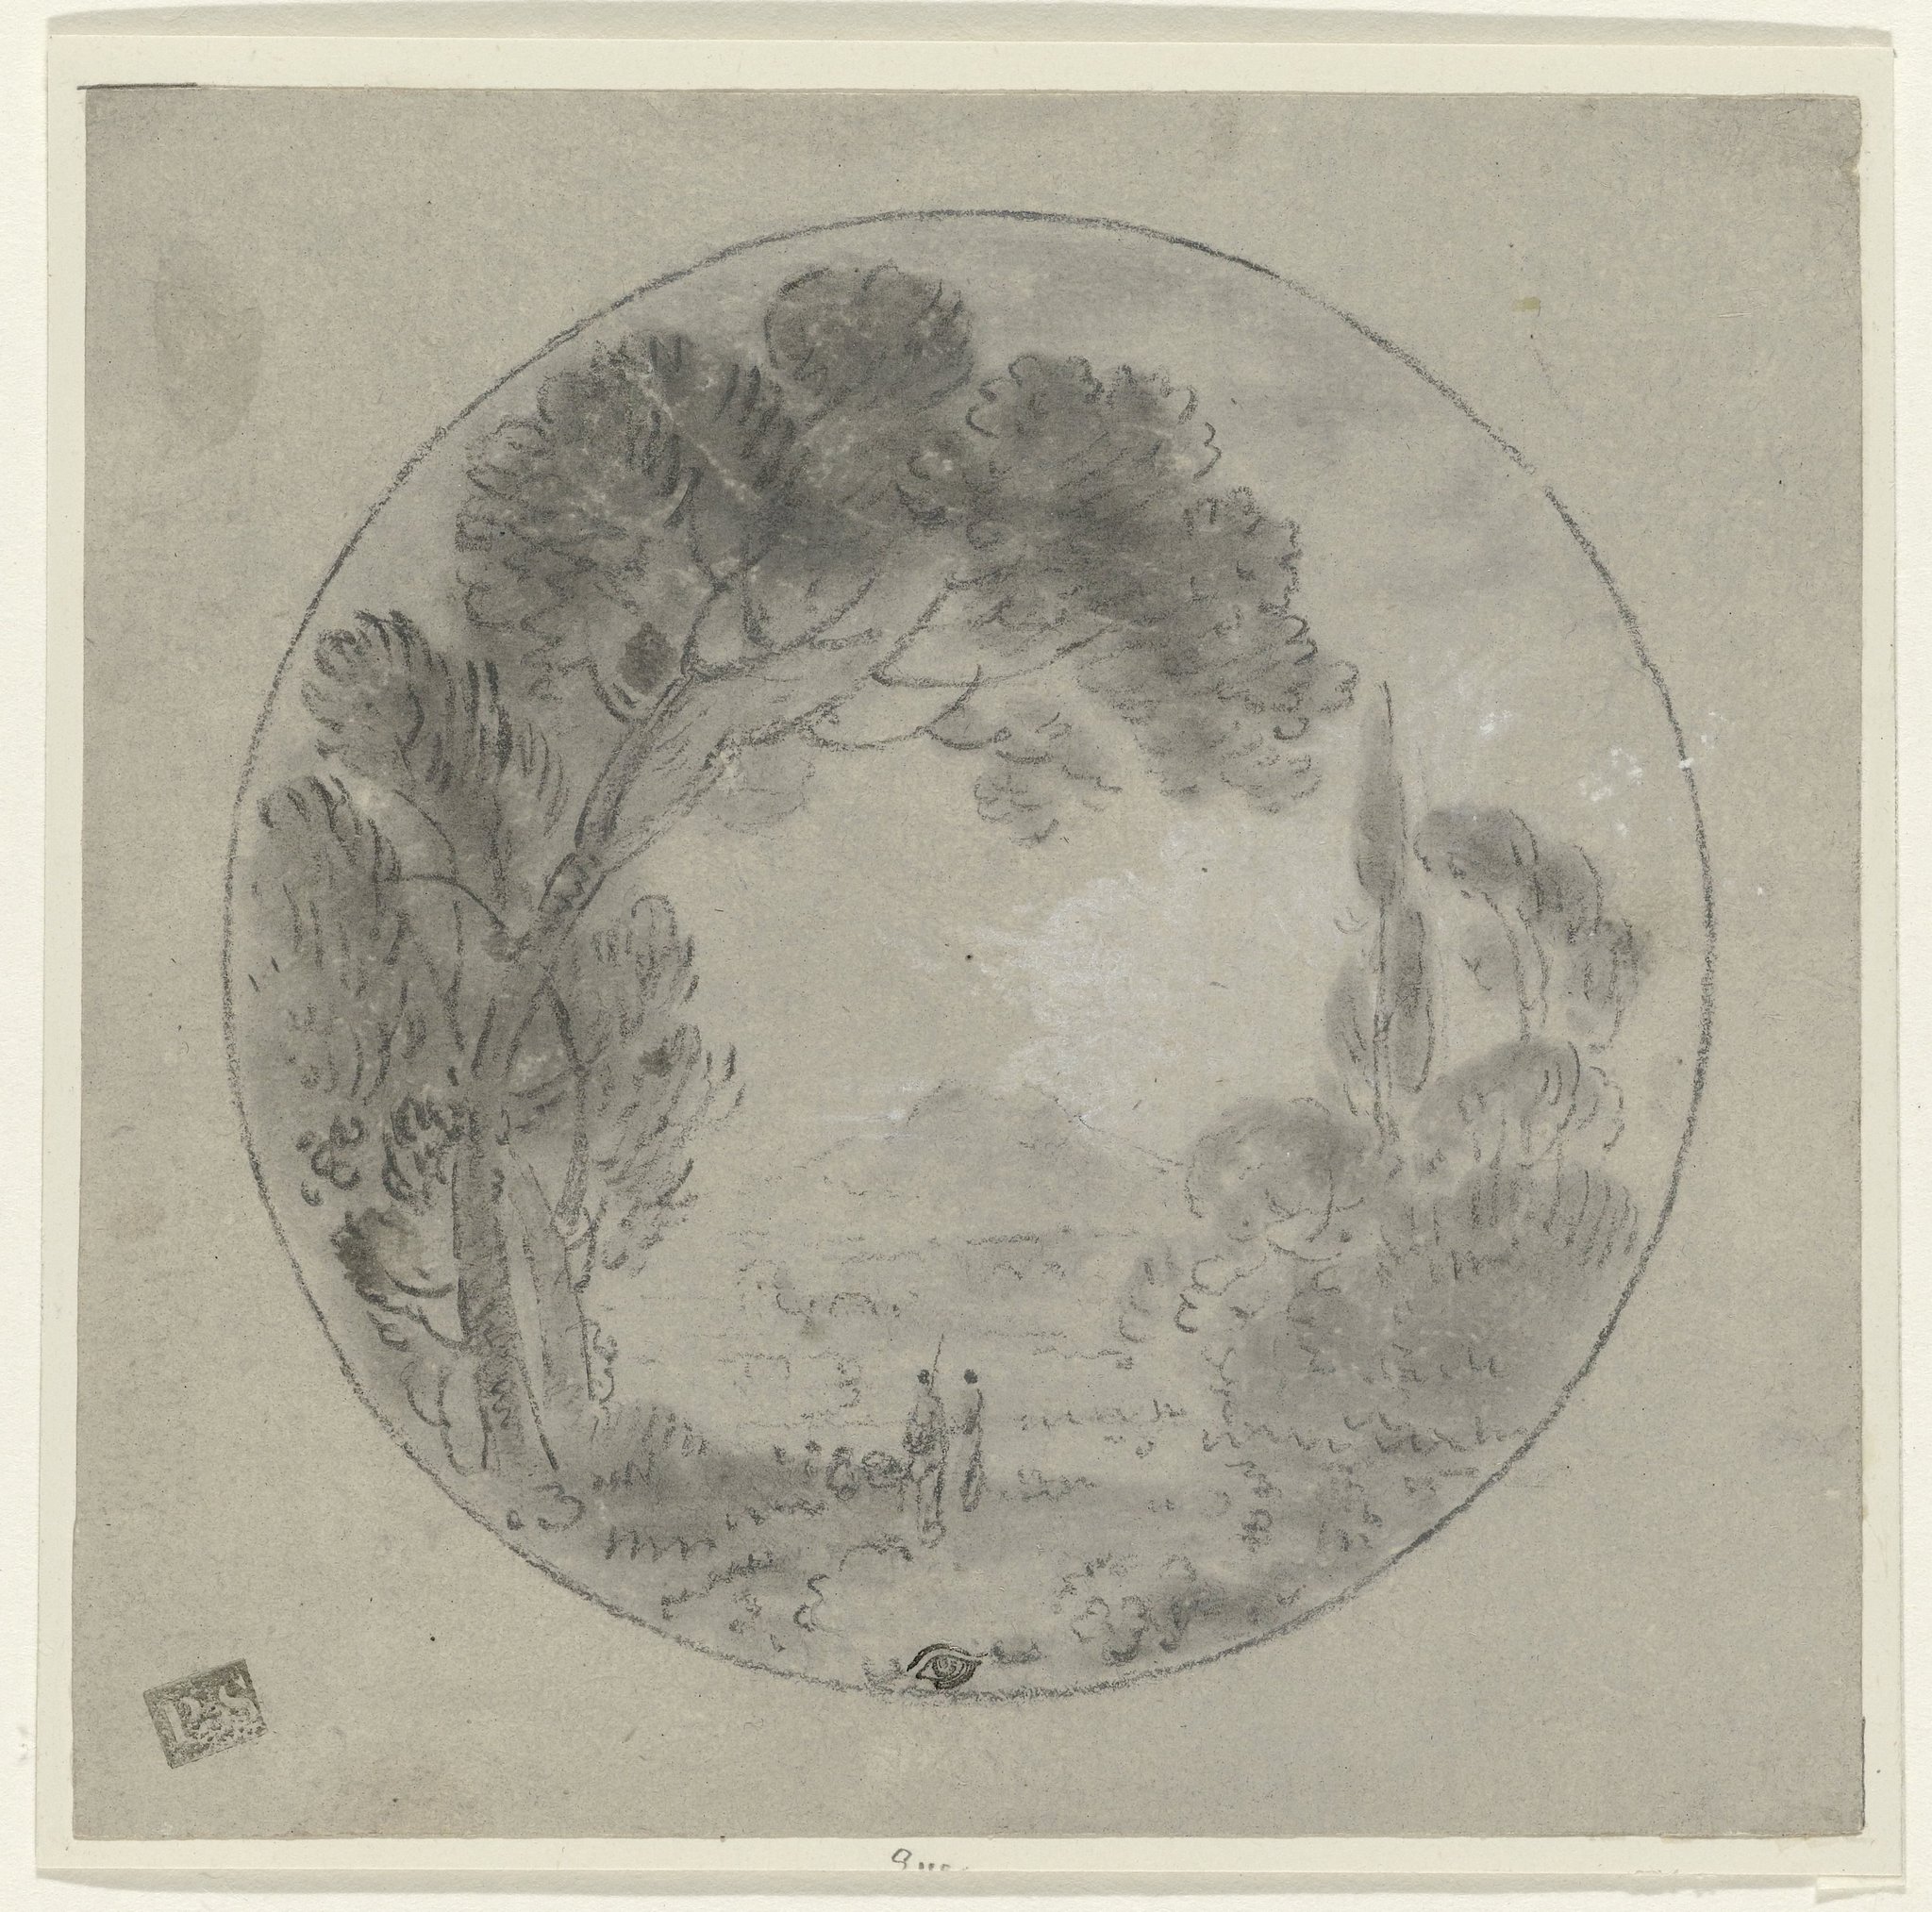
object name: drawing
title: Italiaans landschap met twee figuren in een park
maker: richard wilson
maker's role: draughtsman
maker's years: 1714-1782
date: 1754-1756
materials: chalk, paper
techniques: brush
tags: park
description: Italiaans landschap: twee figuren in een park bij avond, de bomen laten een doorkijk toe over een verschiet waarboven een lichte nevel te zien is.